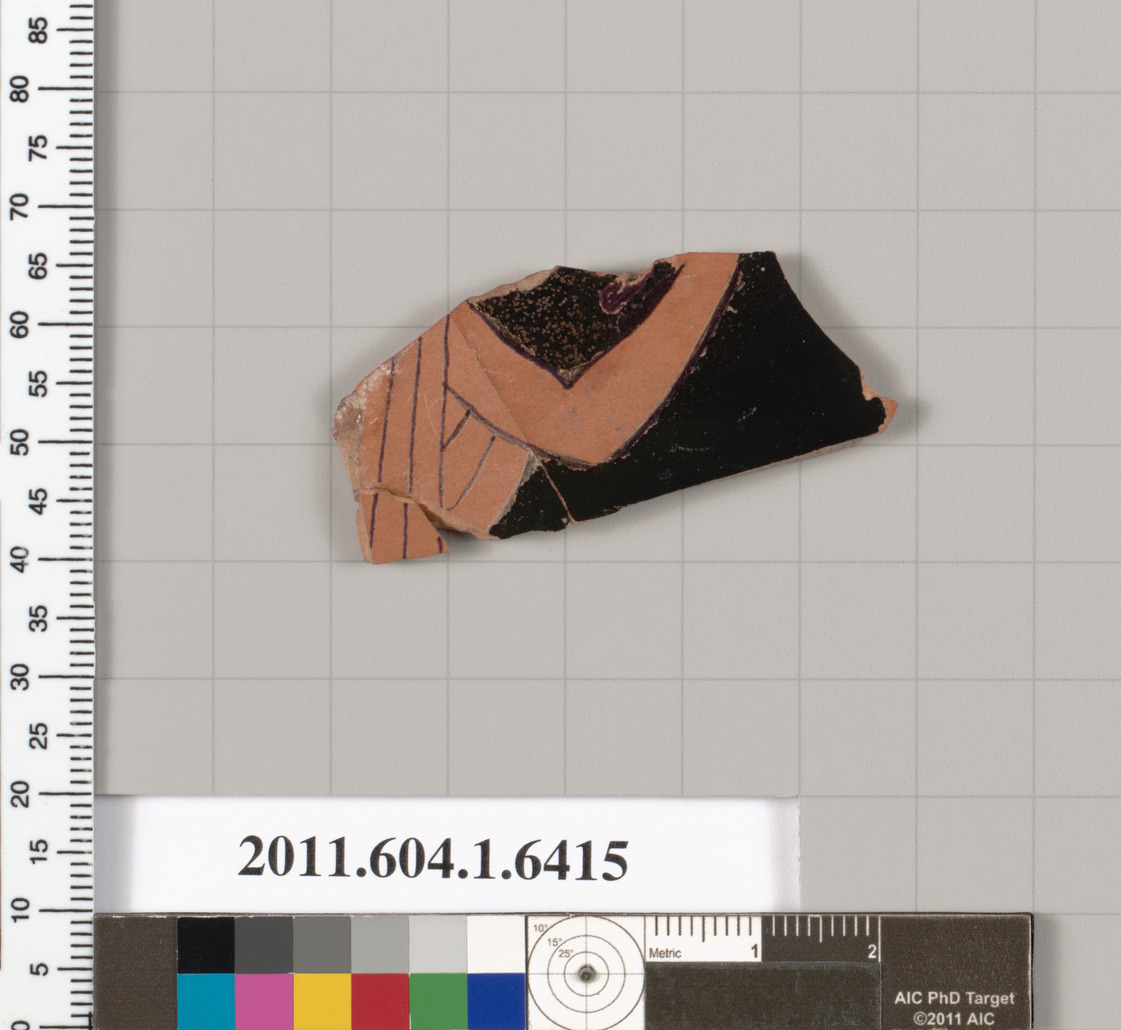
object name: kylix fragment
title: Terracotta fragment of a kylix (drinking cup)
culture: greek, attic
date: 490-480 BCE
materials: terracotta